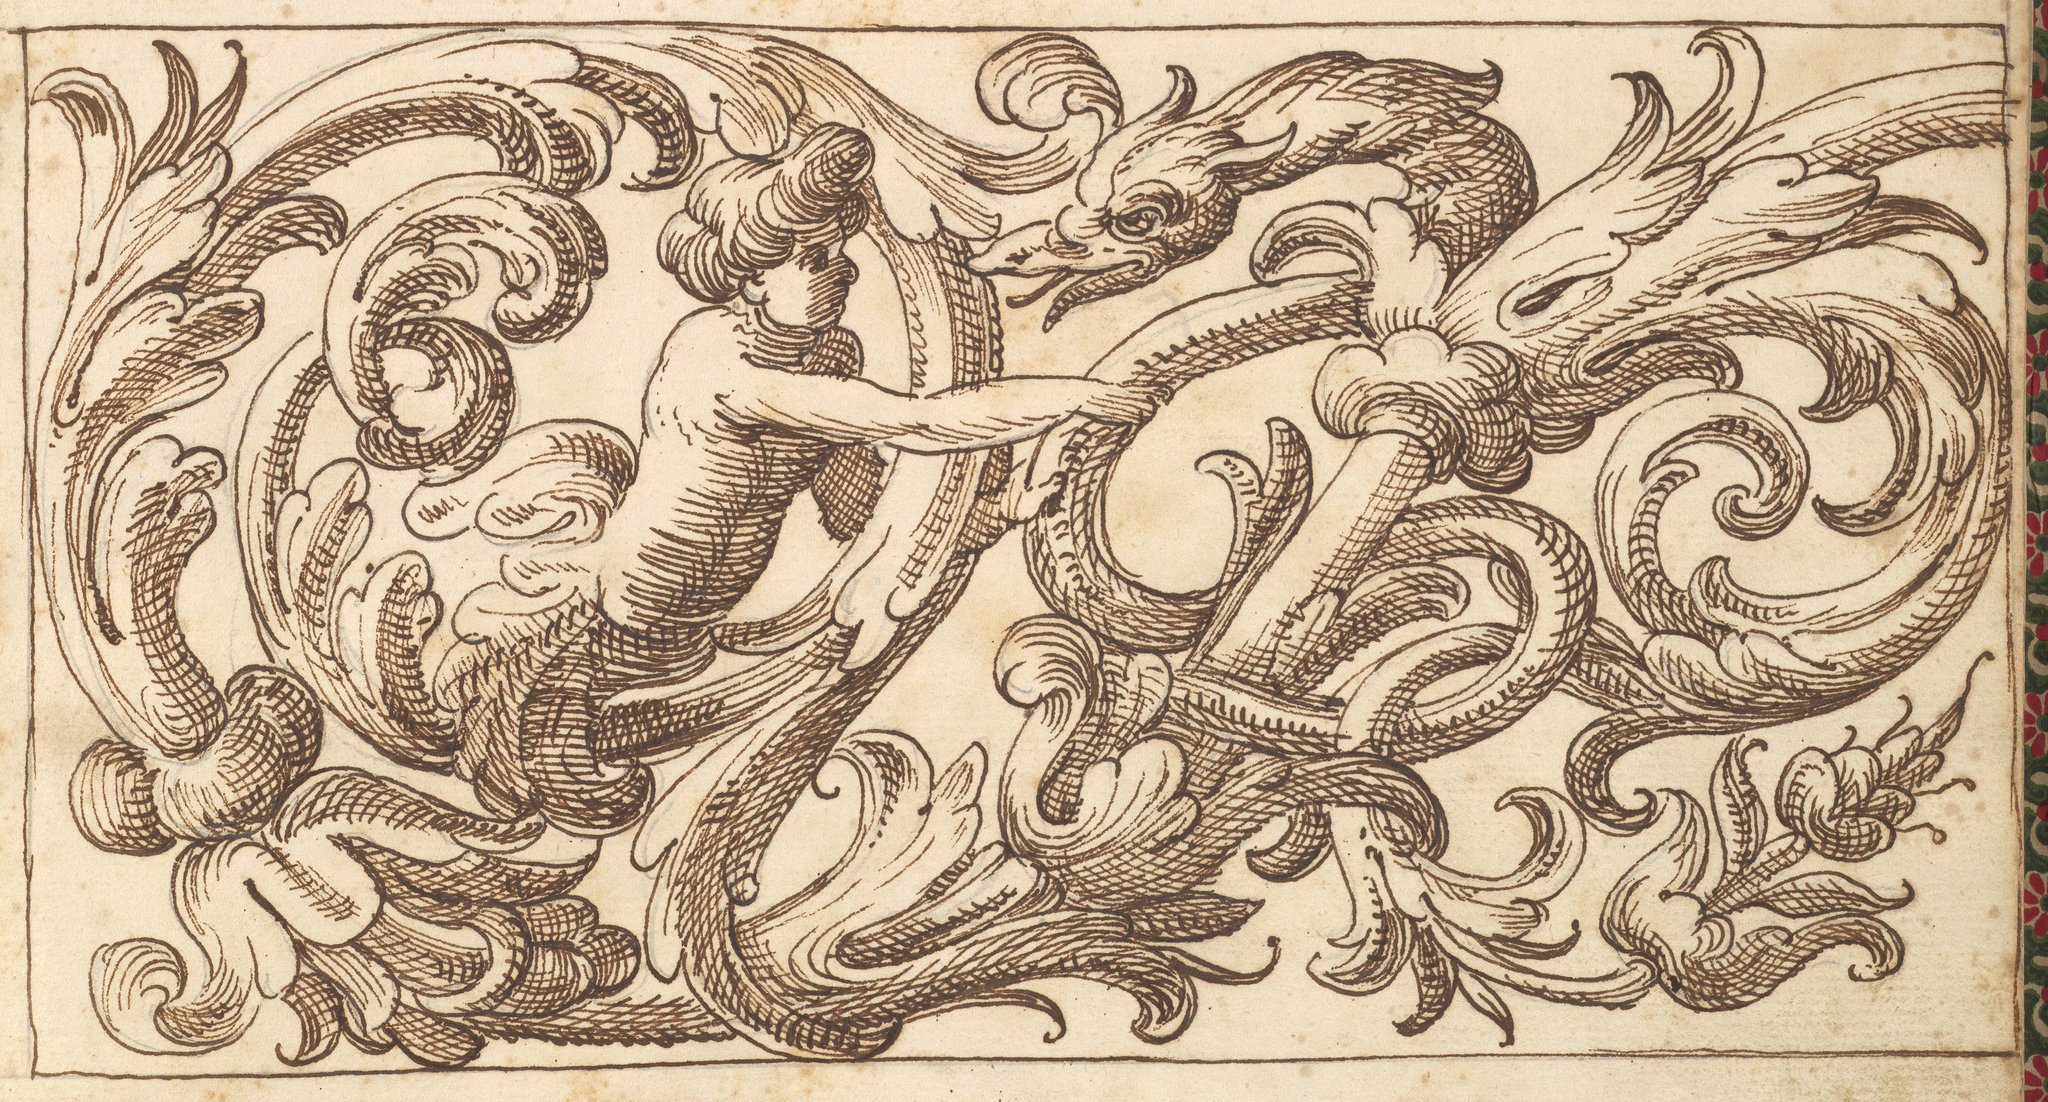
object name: collection ornament architecture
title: Horizontal Panel Design with a Young Man and a Fantastical Creature Interspersed between Acanthus Rinceaux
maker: anonymous, italian, venetian, 17th century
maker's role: artist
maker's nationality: italian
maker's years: 1600-1700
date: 1601-1700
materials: ink, drawing material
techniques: pen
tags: men,acanthus